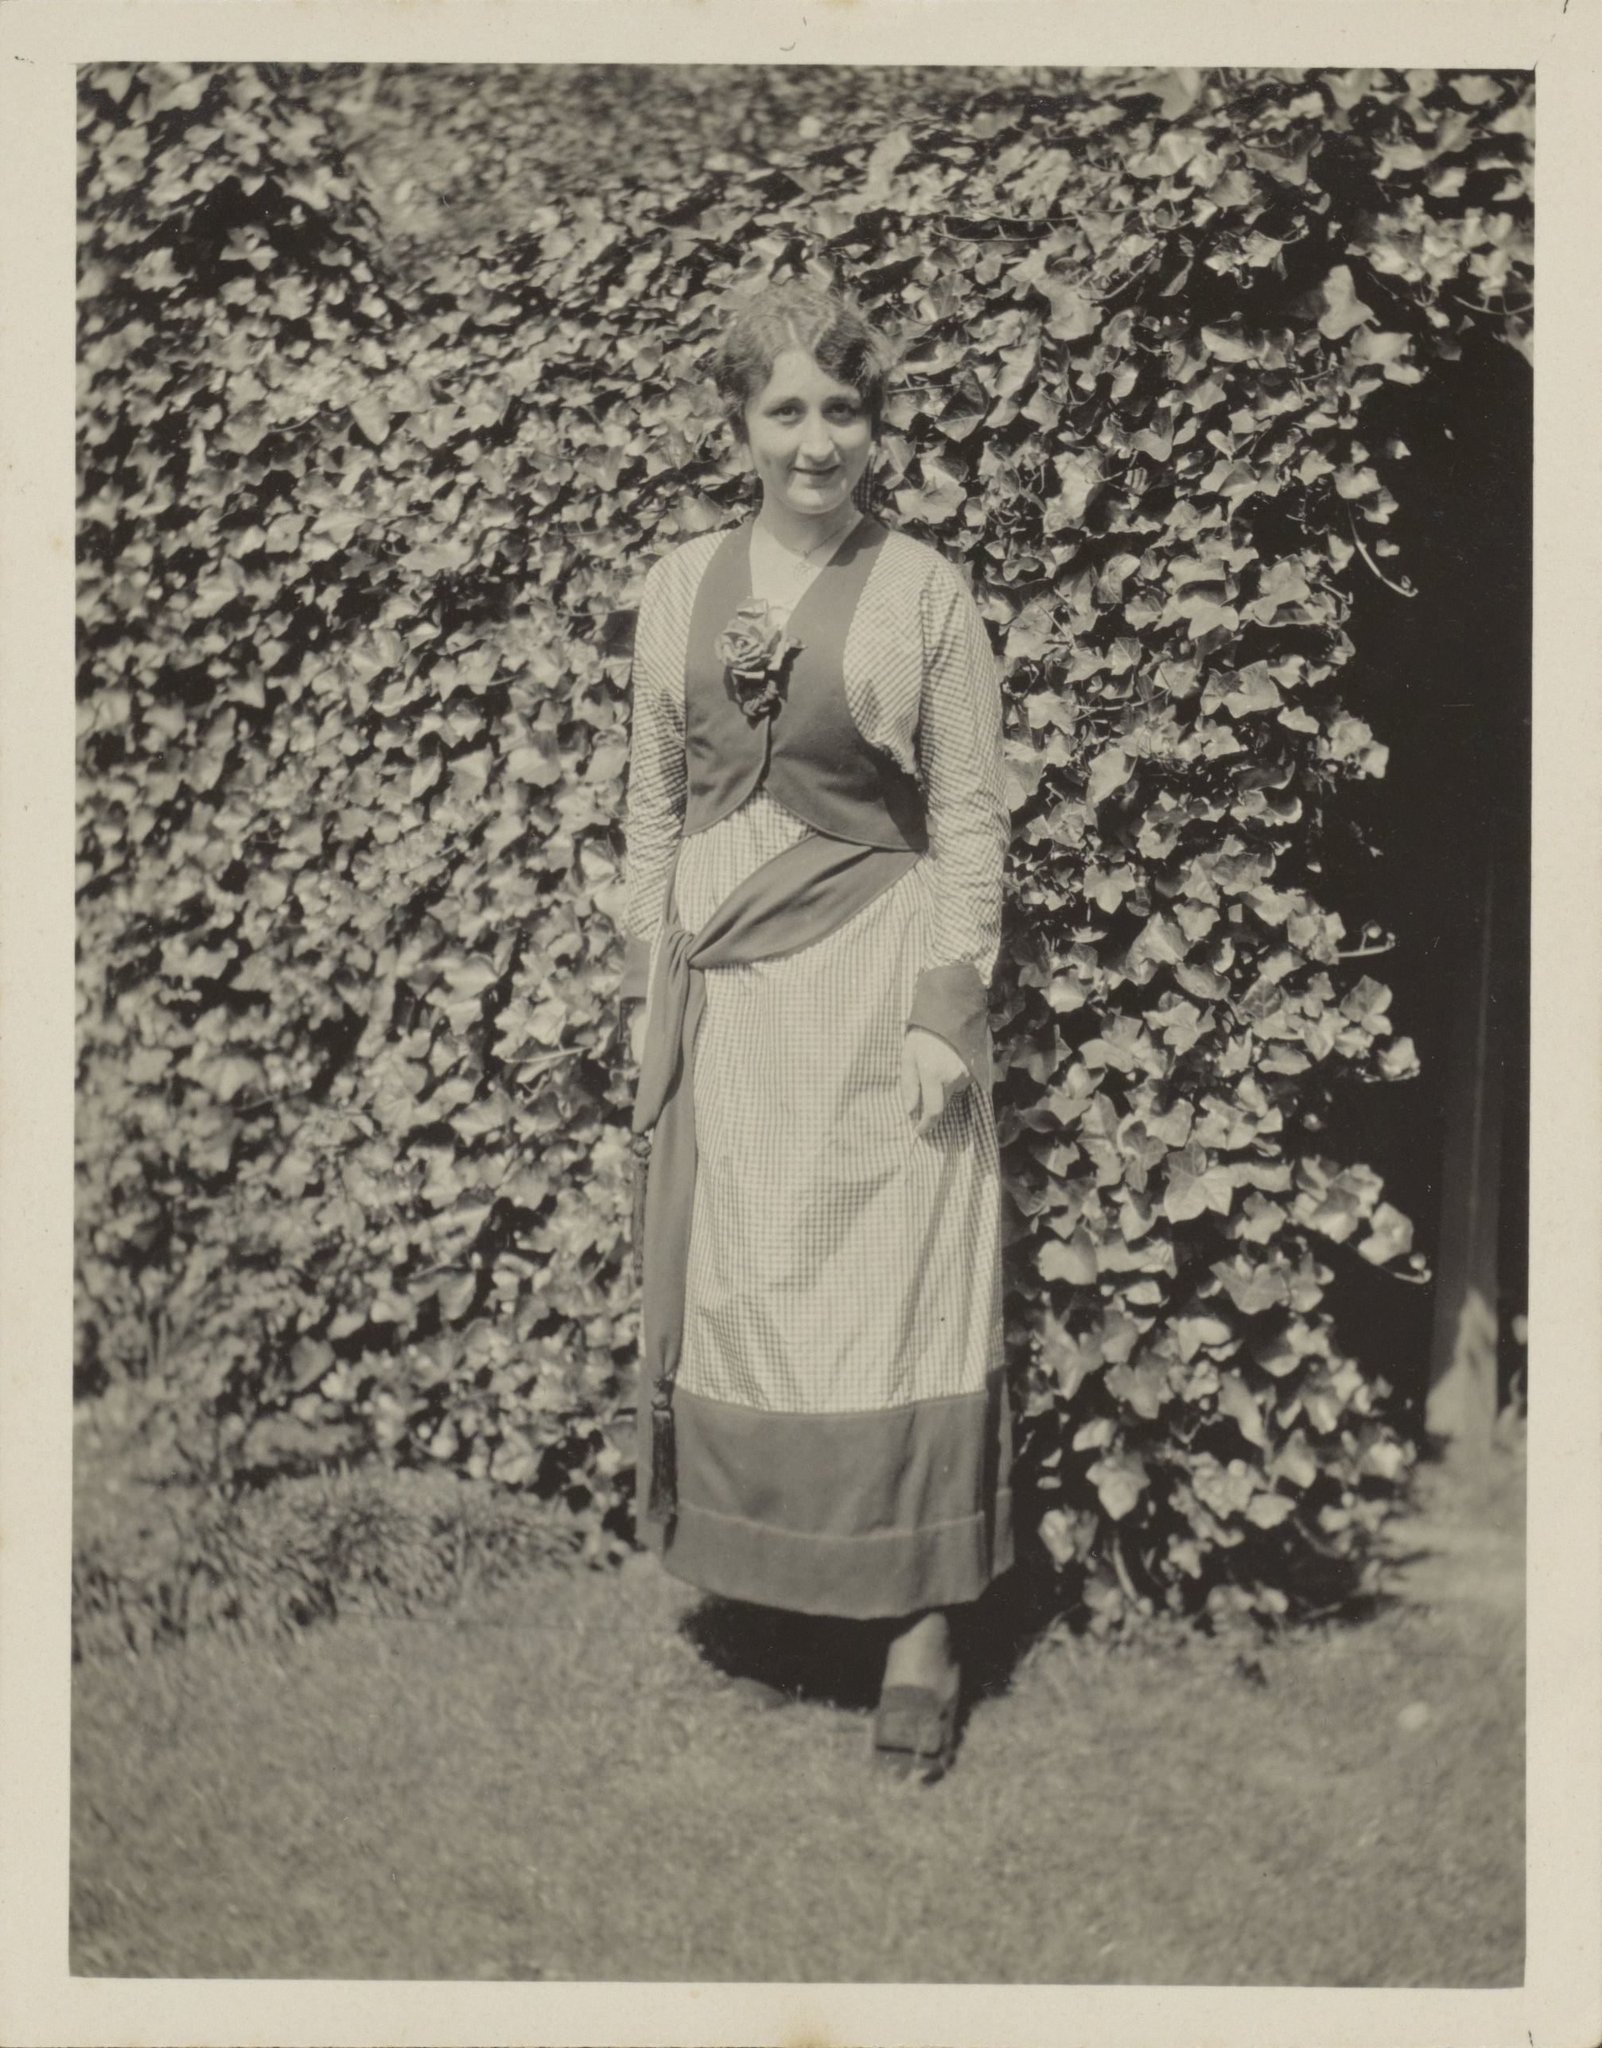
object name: photograph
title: Portret van een vrouw in een geruite jurk te Wimbledon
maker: Anonymous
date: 1915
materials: photographic support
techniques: gelatin silver print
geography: wimbledon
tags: dress, gown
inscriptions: inscription: ‘Wimbledon 20 Aug. 1915.’